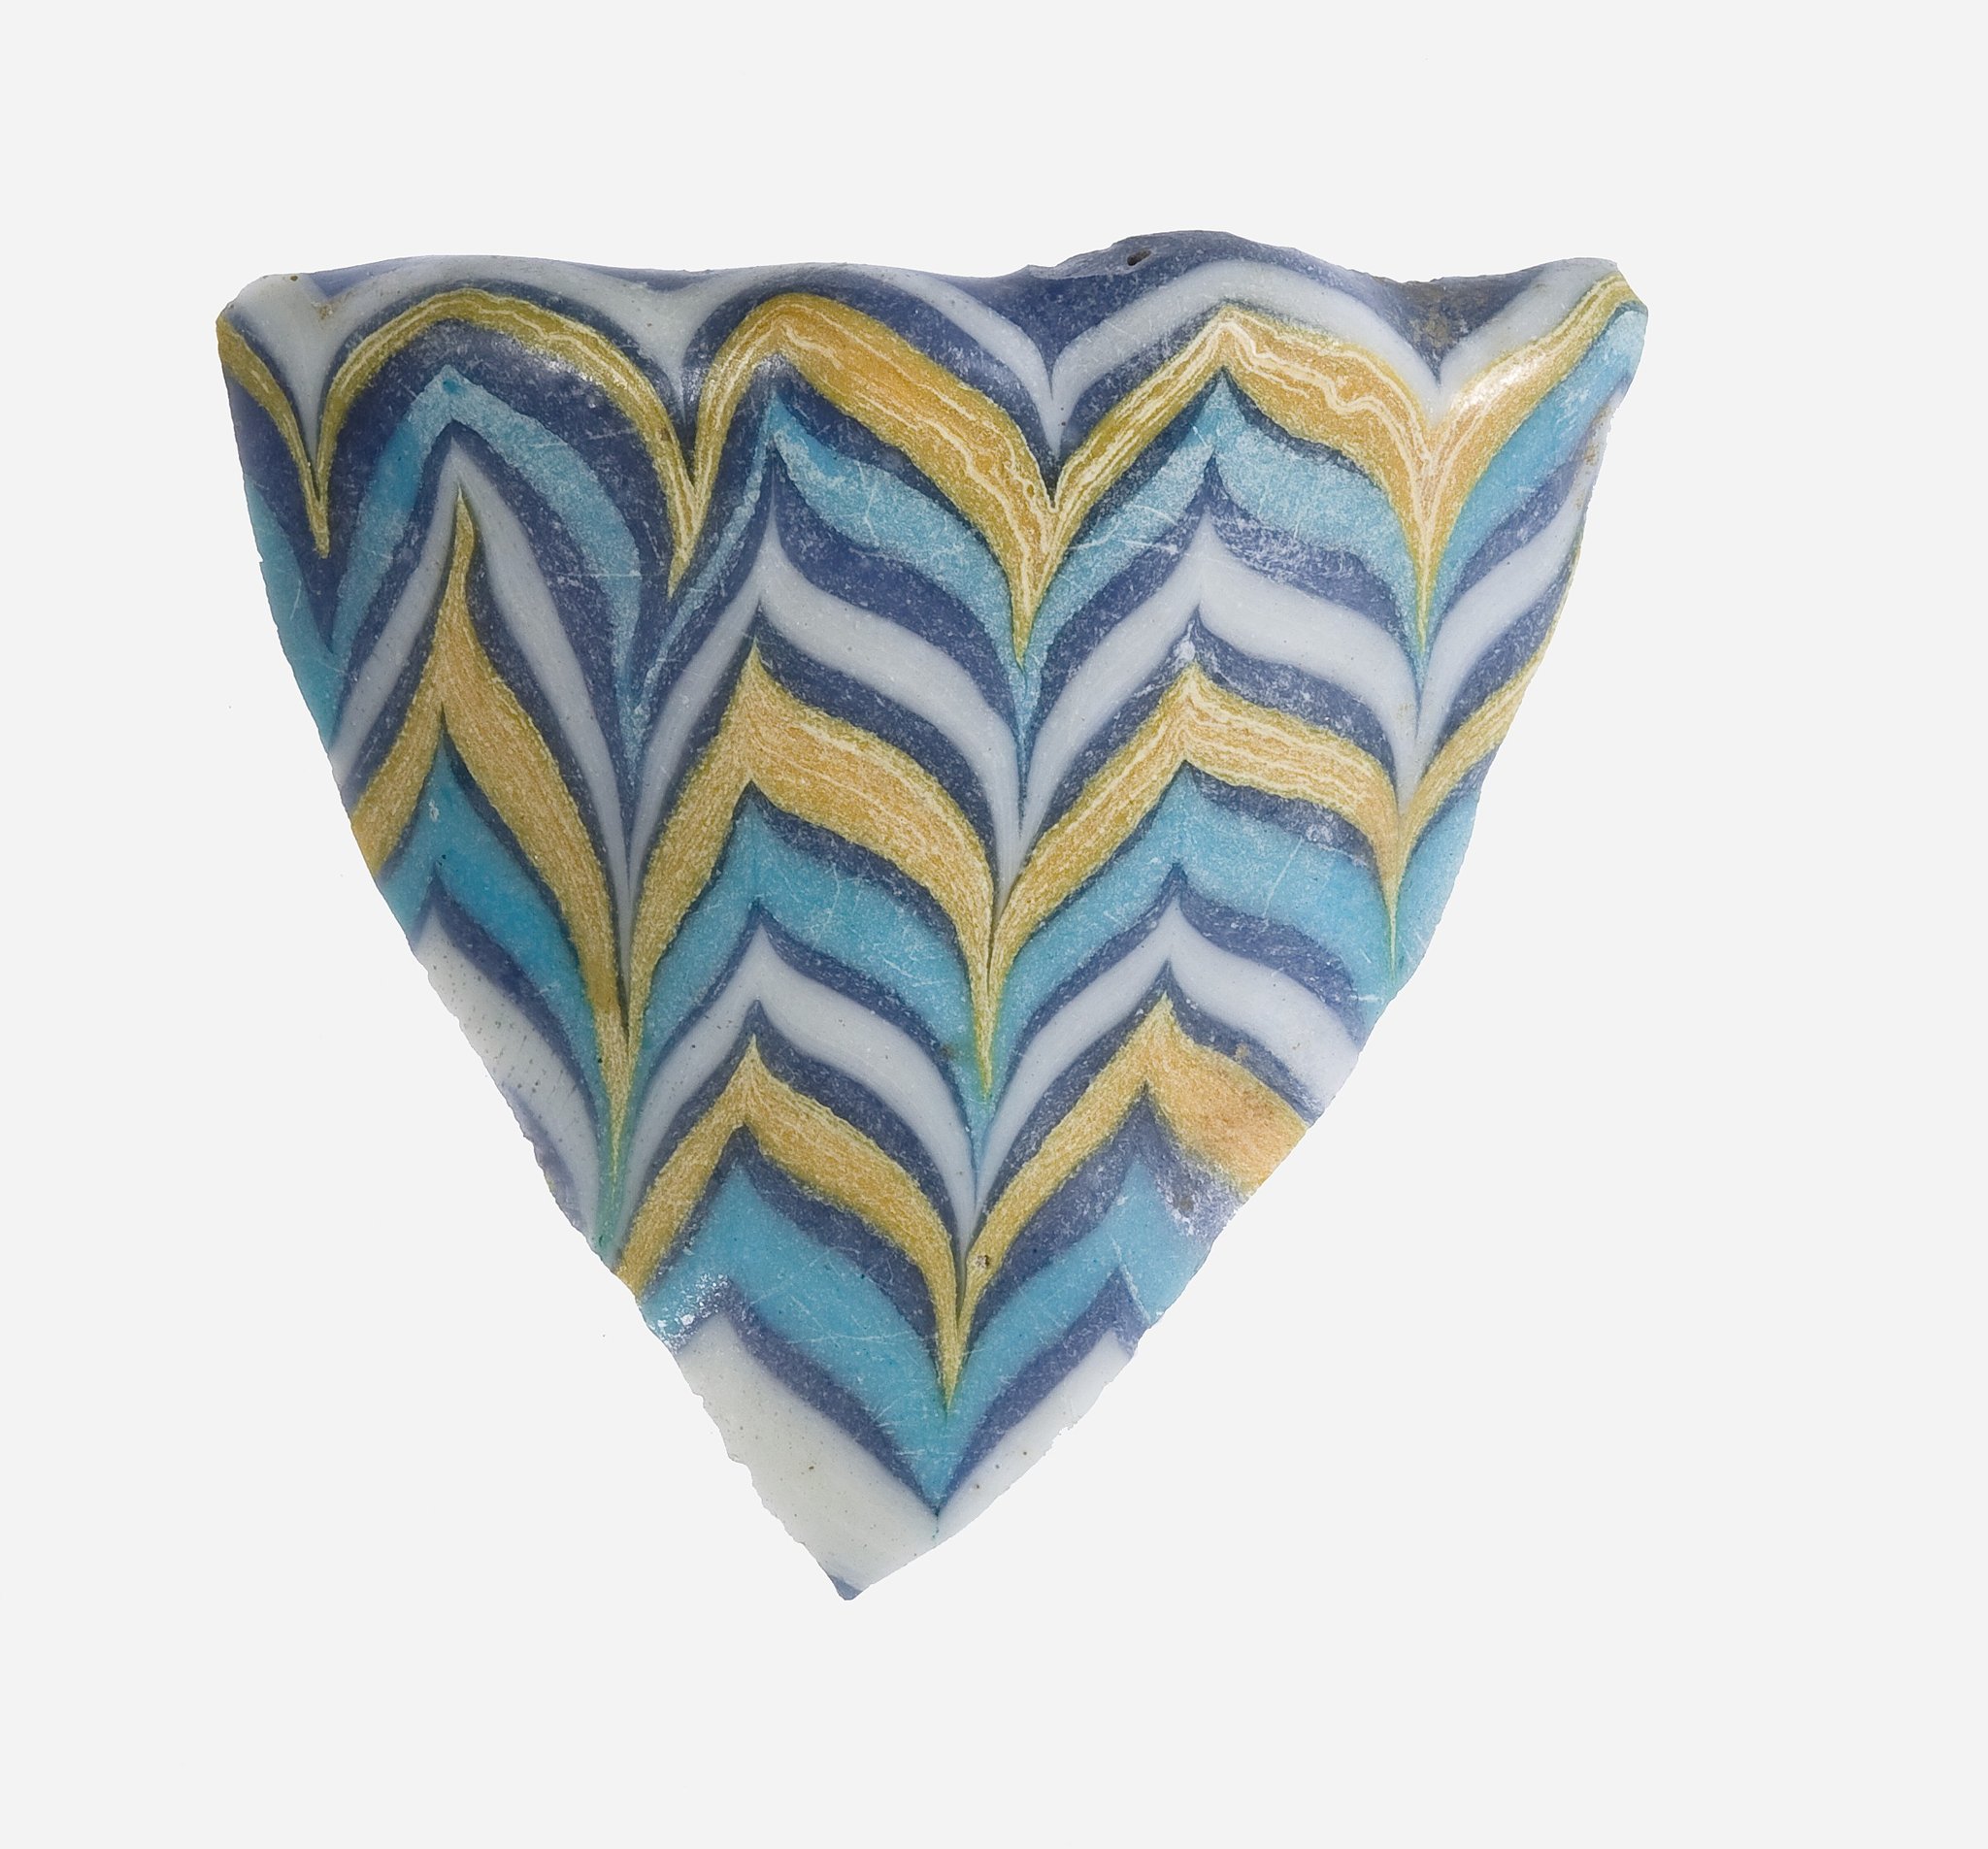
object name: vase fragment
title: Body Fragment of a Glass Vase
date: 1390-1352 BCE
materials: glass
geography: egypt